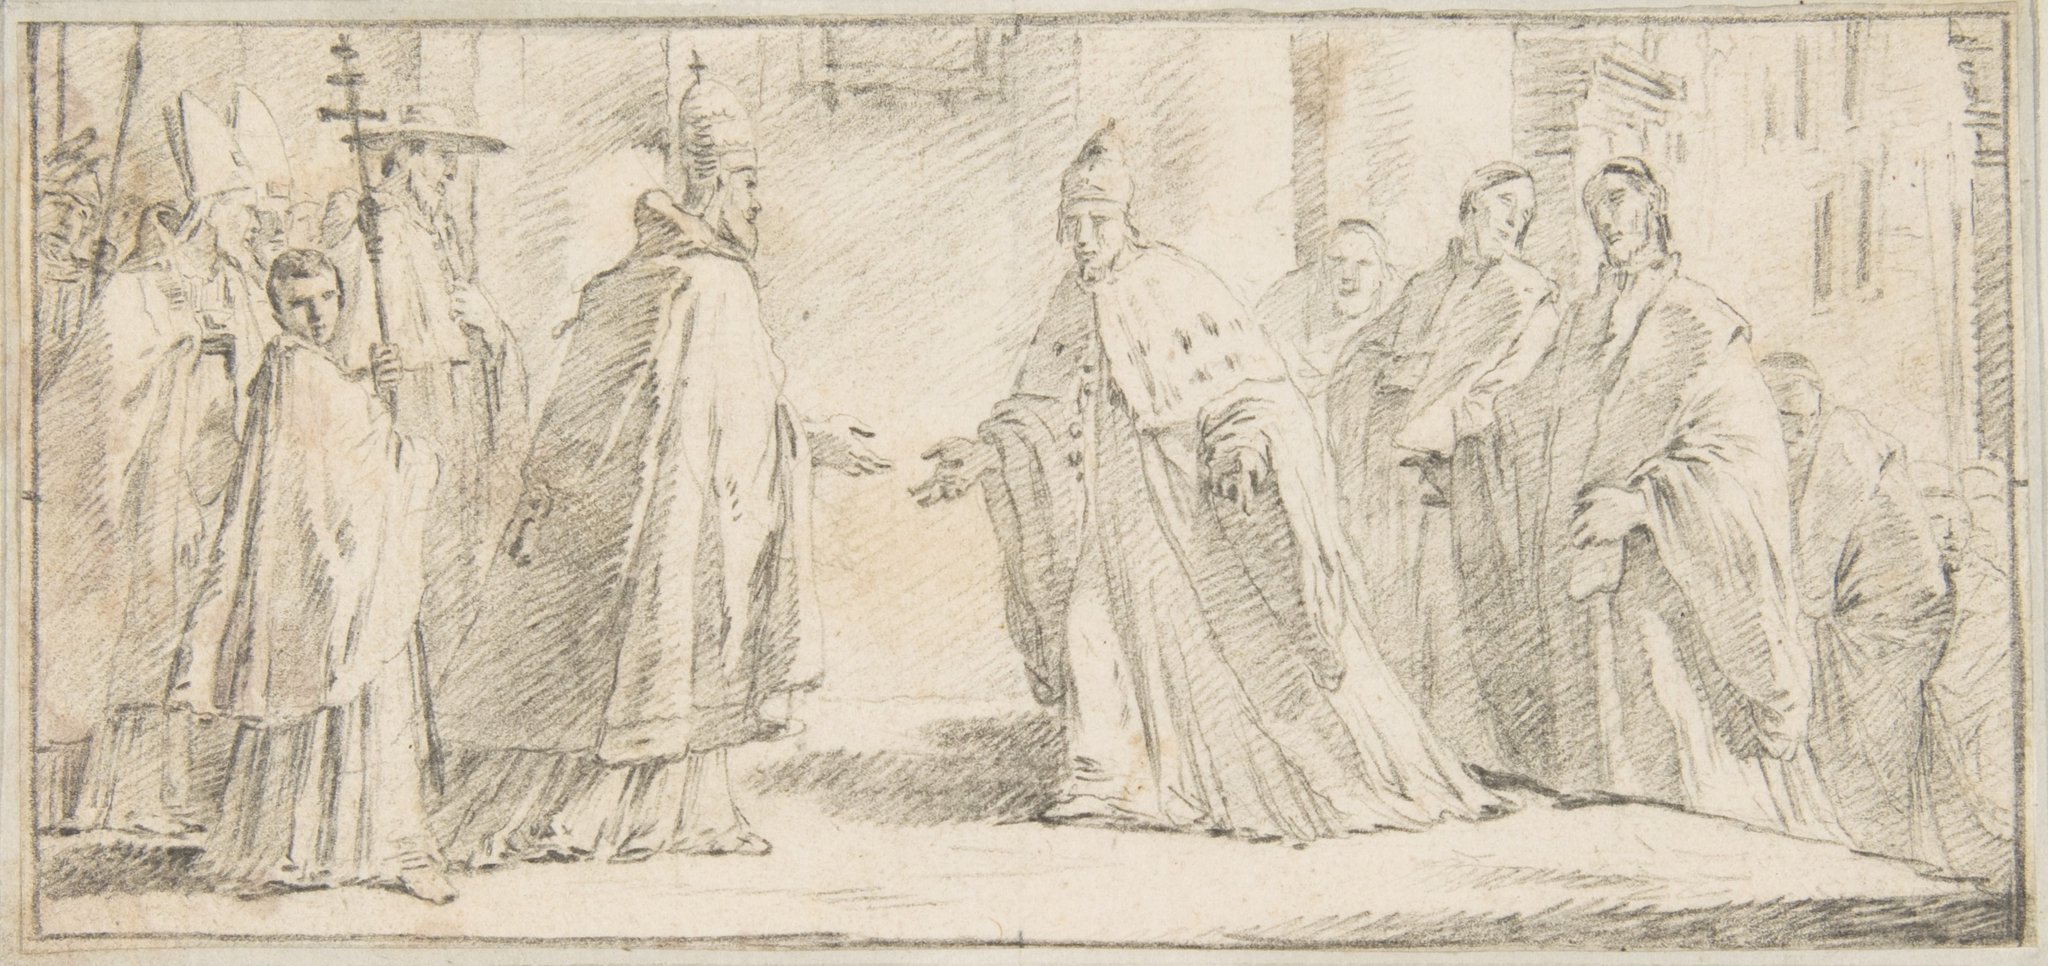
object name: drawing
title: Illustration for a Book: Meeting Between a Pope and Doge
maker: giovanni battista tiepolo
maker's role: artist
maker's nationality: italian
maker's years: 1696-1770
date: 1696-1770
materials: chalk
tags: boys,men,popes